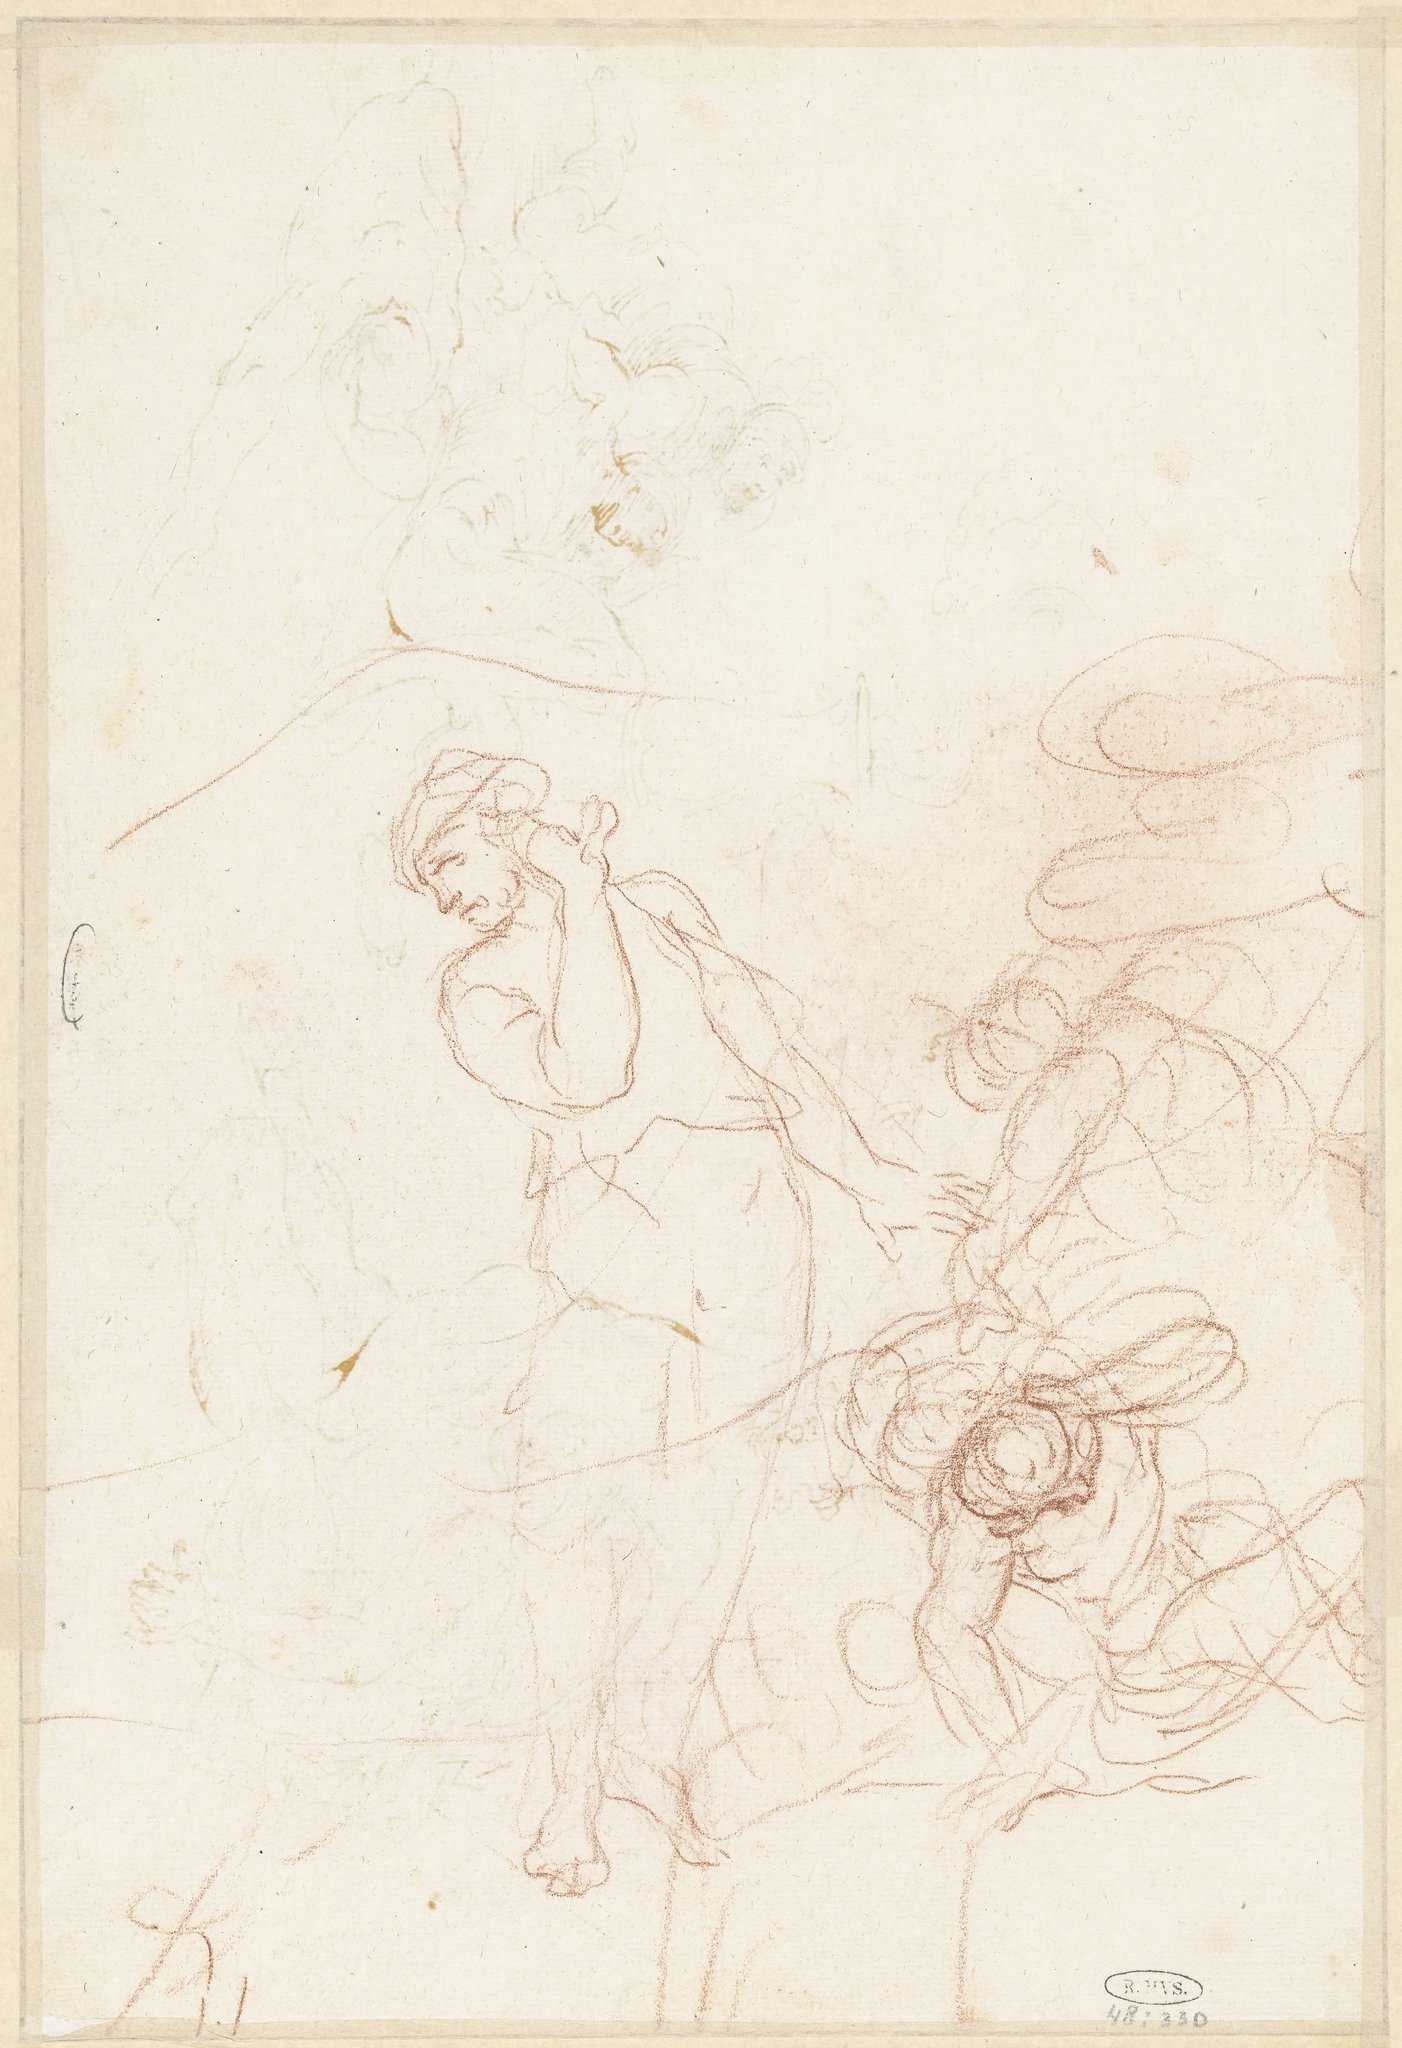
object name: drawing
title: Schets van vechtende figuren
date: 1600-1699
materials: chalk, paper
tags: hand-to-hand fighting (~ battle)